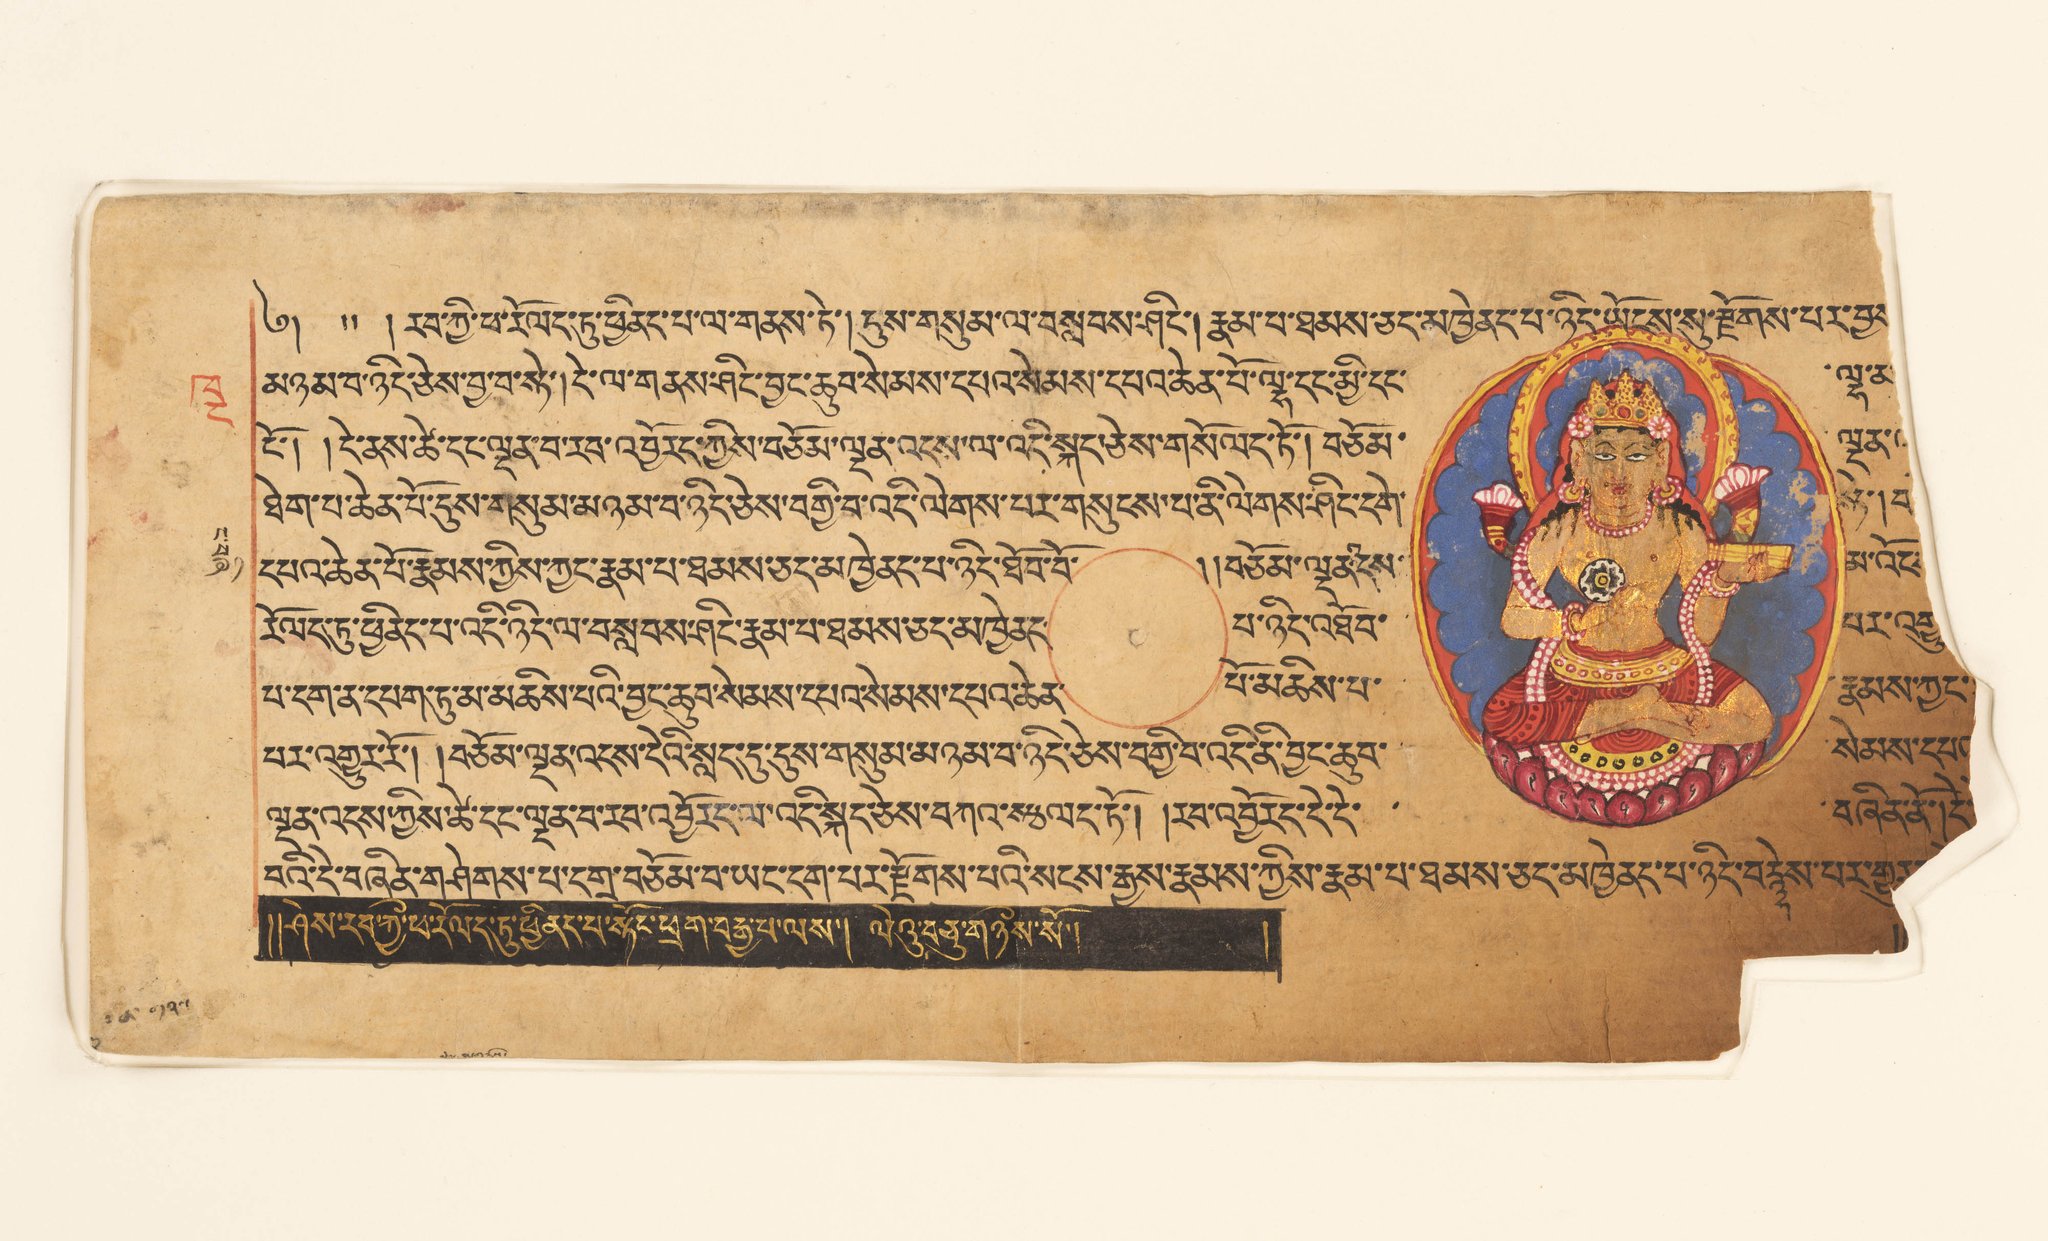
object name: folio fragment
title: Fragment of a Prajnaparamita Sutra manuscript folio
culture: kashmiri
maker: unidentified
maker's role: artist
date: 1001-1100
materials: ink, paper